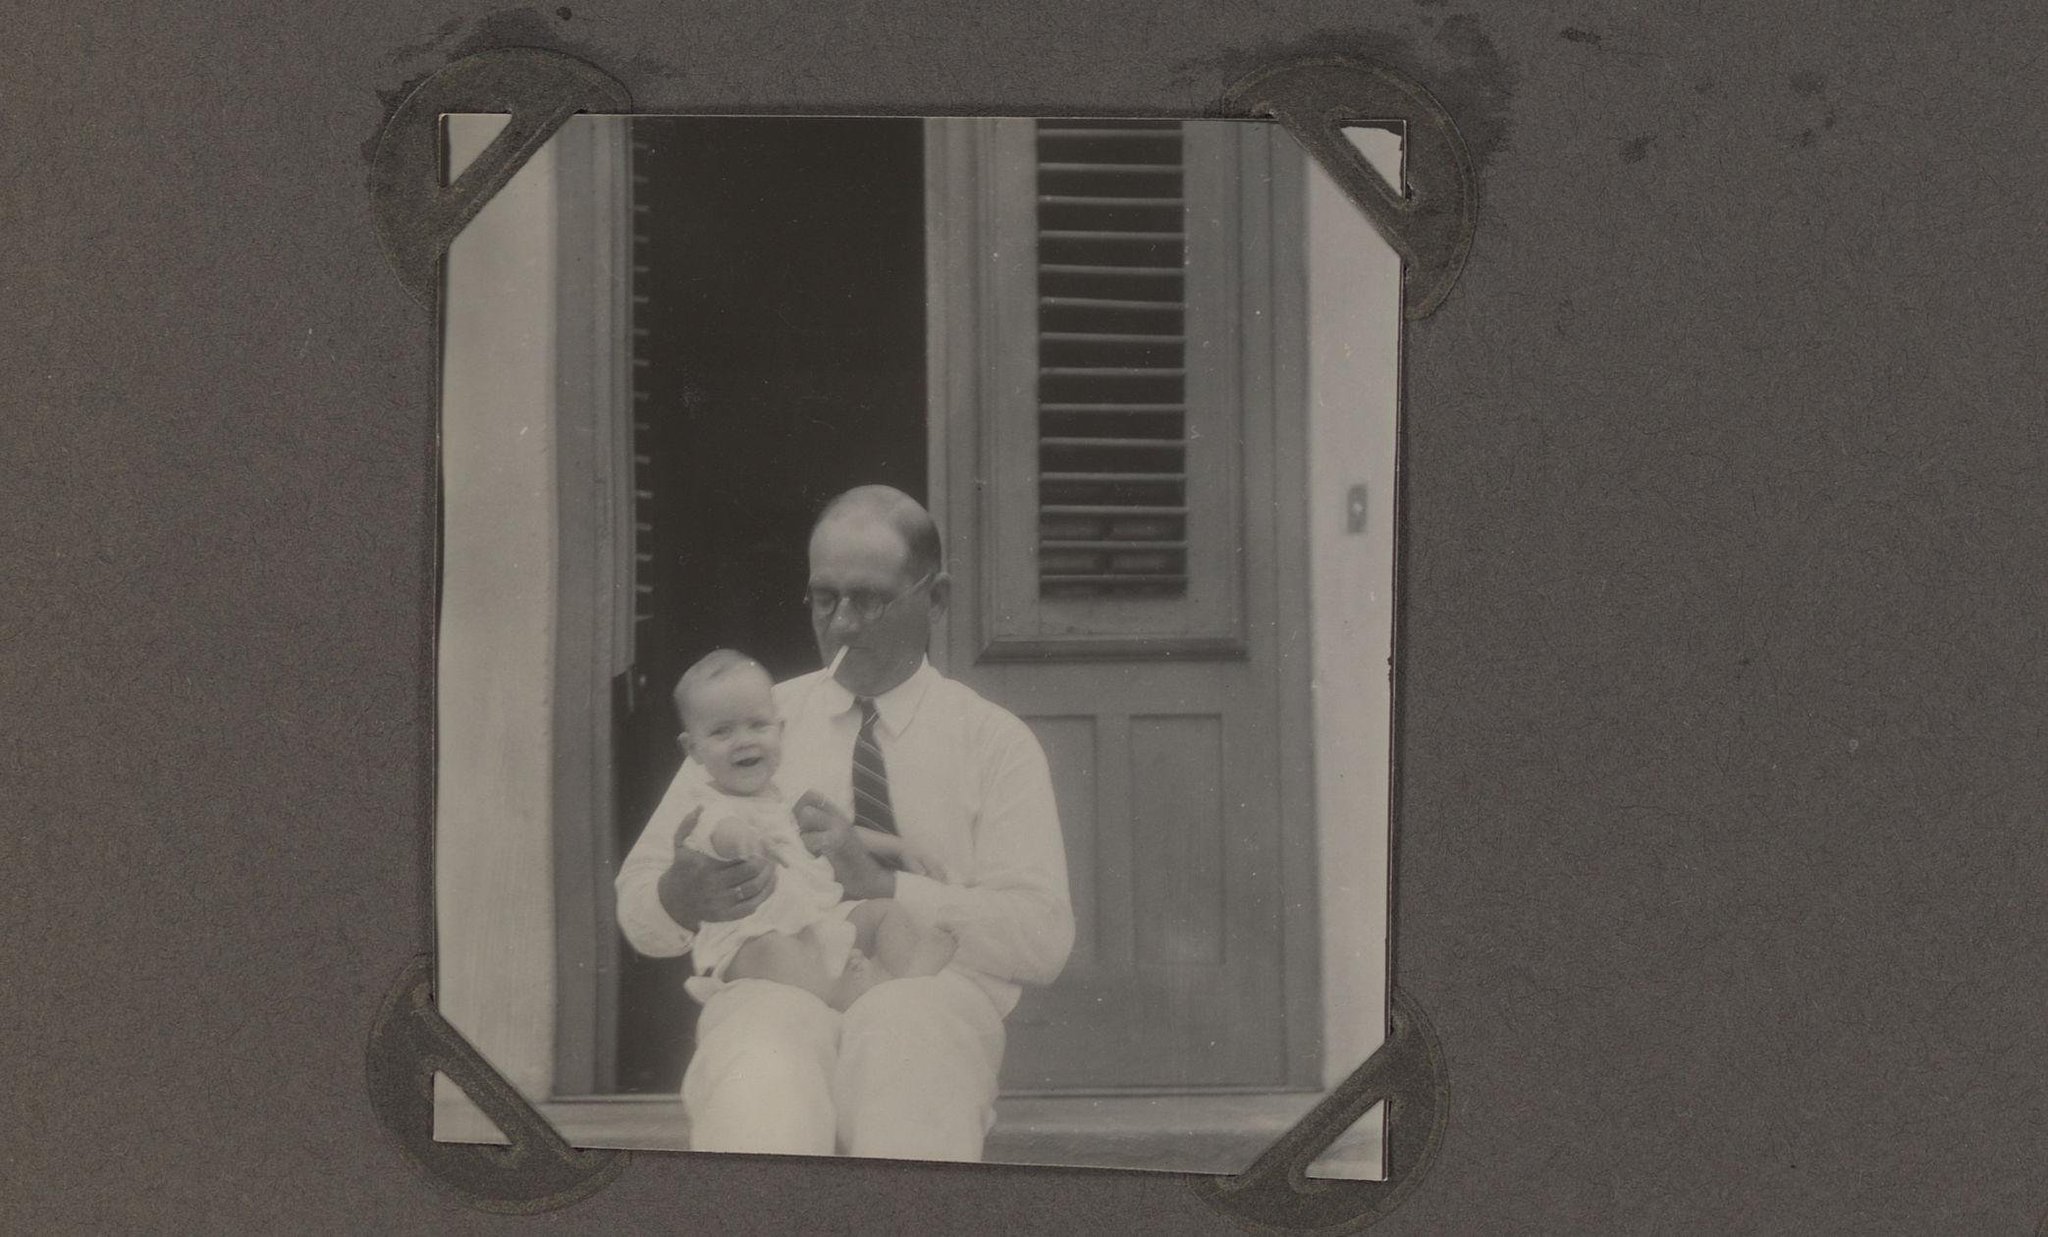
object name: photograph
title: Familiefoto van de kinderen Jetten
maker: Anonymous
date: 1925-1927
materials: photographic support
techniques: photography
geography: suriname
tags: jetten, familie, moengo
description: Familiefoto van de kinderen Jetten met hun vader. Foto op een bladzijde van een los albumblad. Onderdeel van het ensemble met foto's van de familie van ingenieur Jetten in de mijnbouwstad Moengo in Suriname.